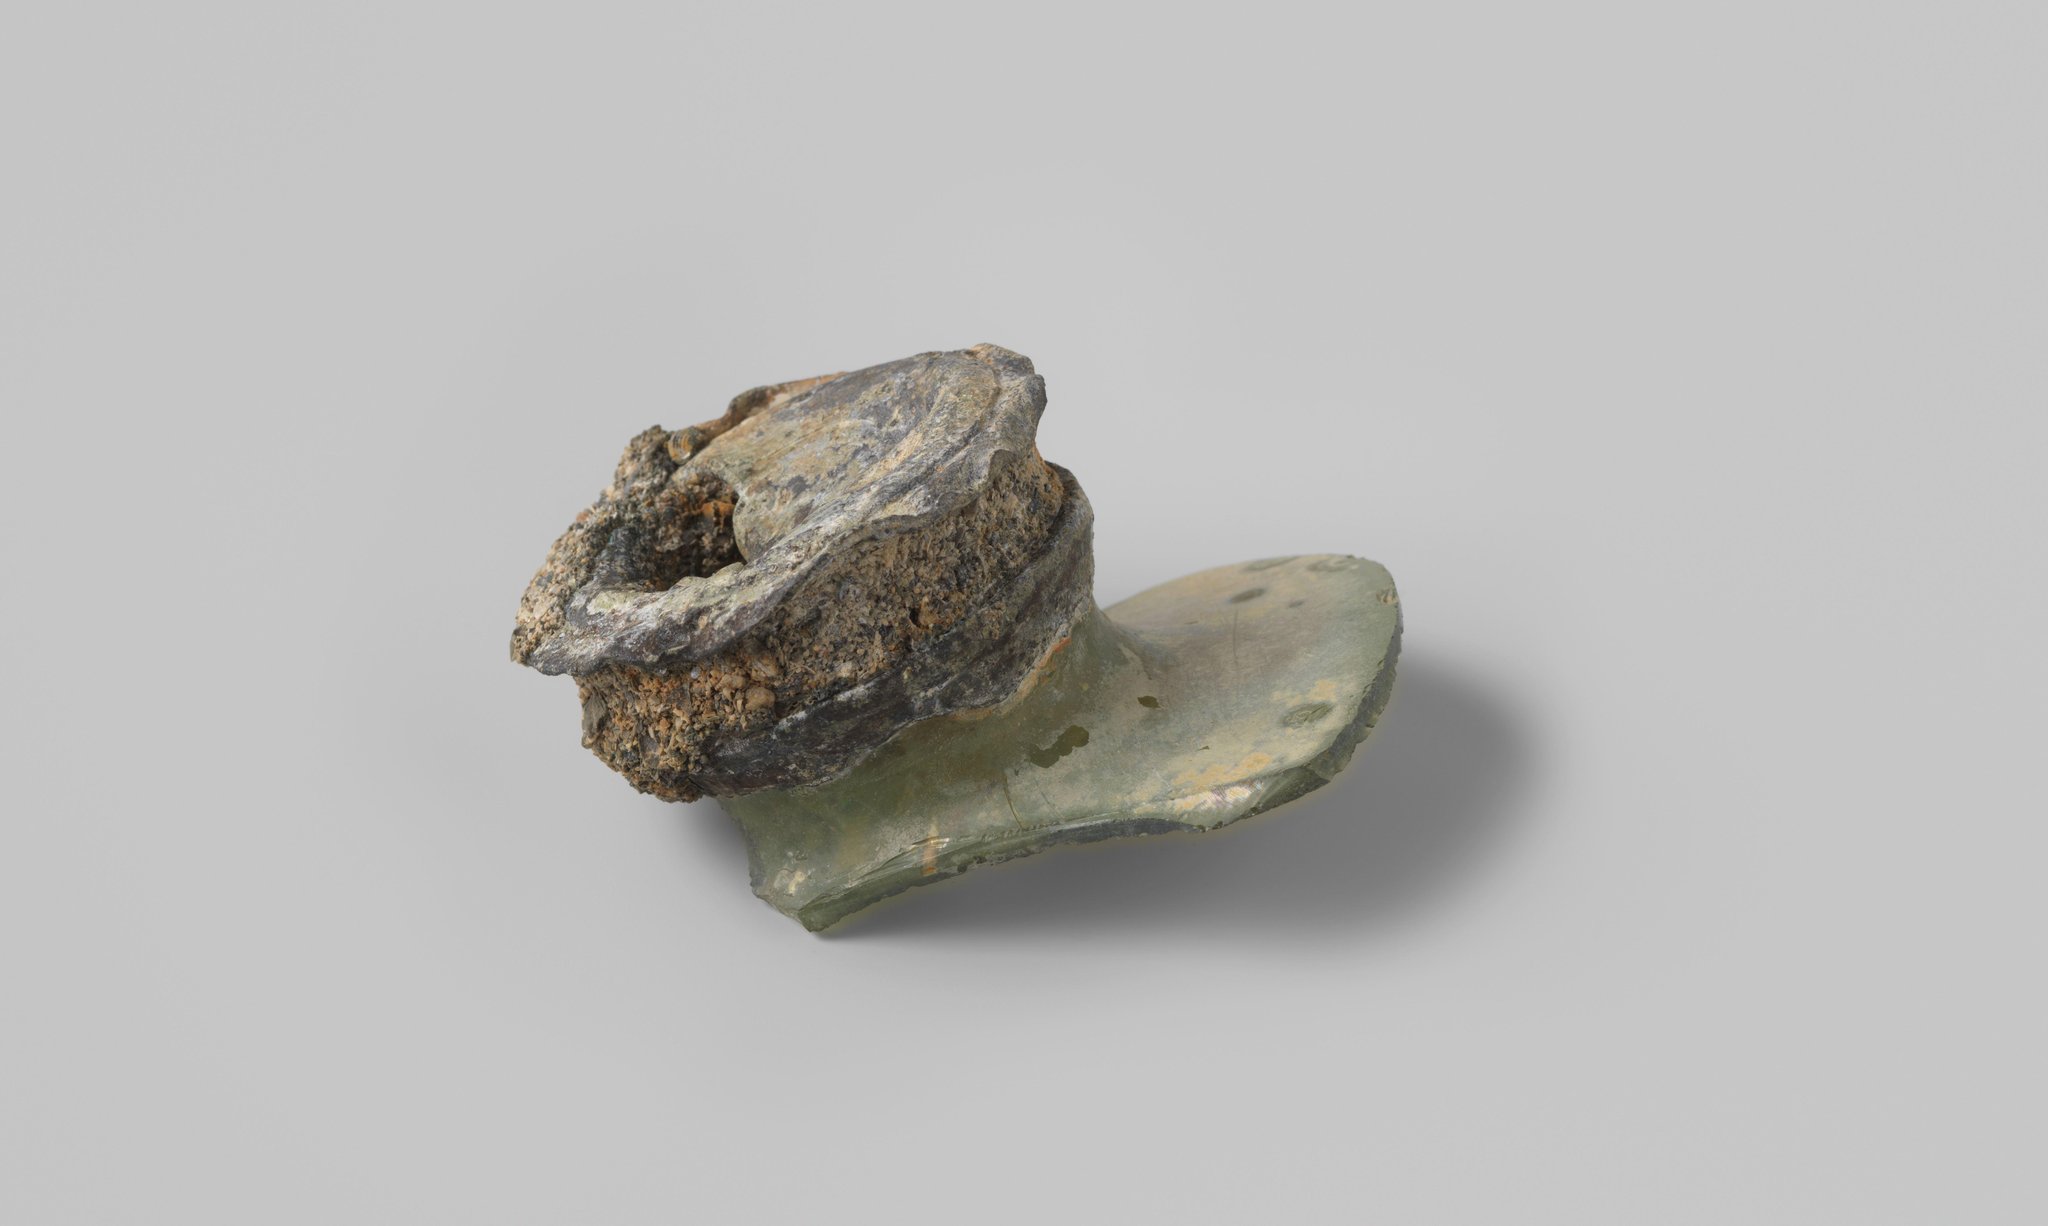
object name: case bottle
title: Fragment kelderfles met schroefdop uit een scheepswrak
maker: Anonymous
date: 1700-1735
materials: glass, tin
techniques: green glass